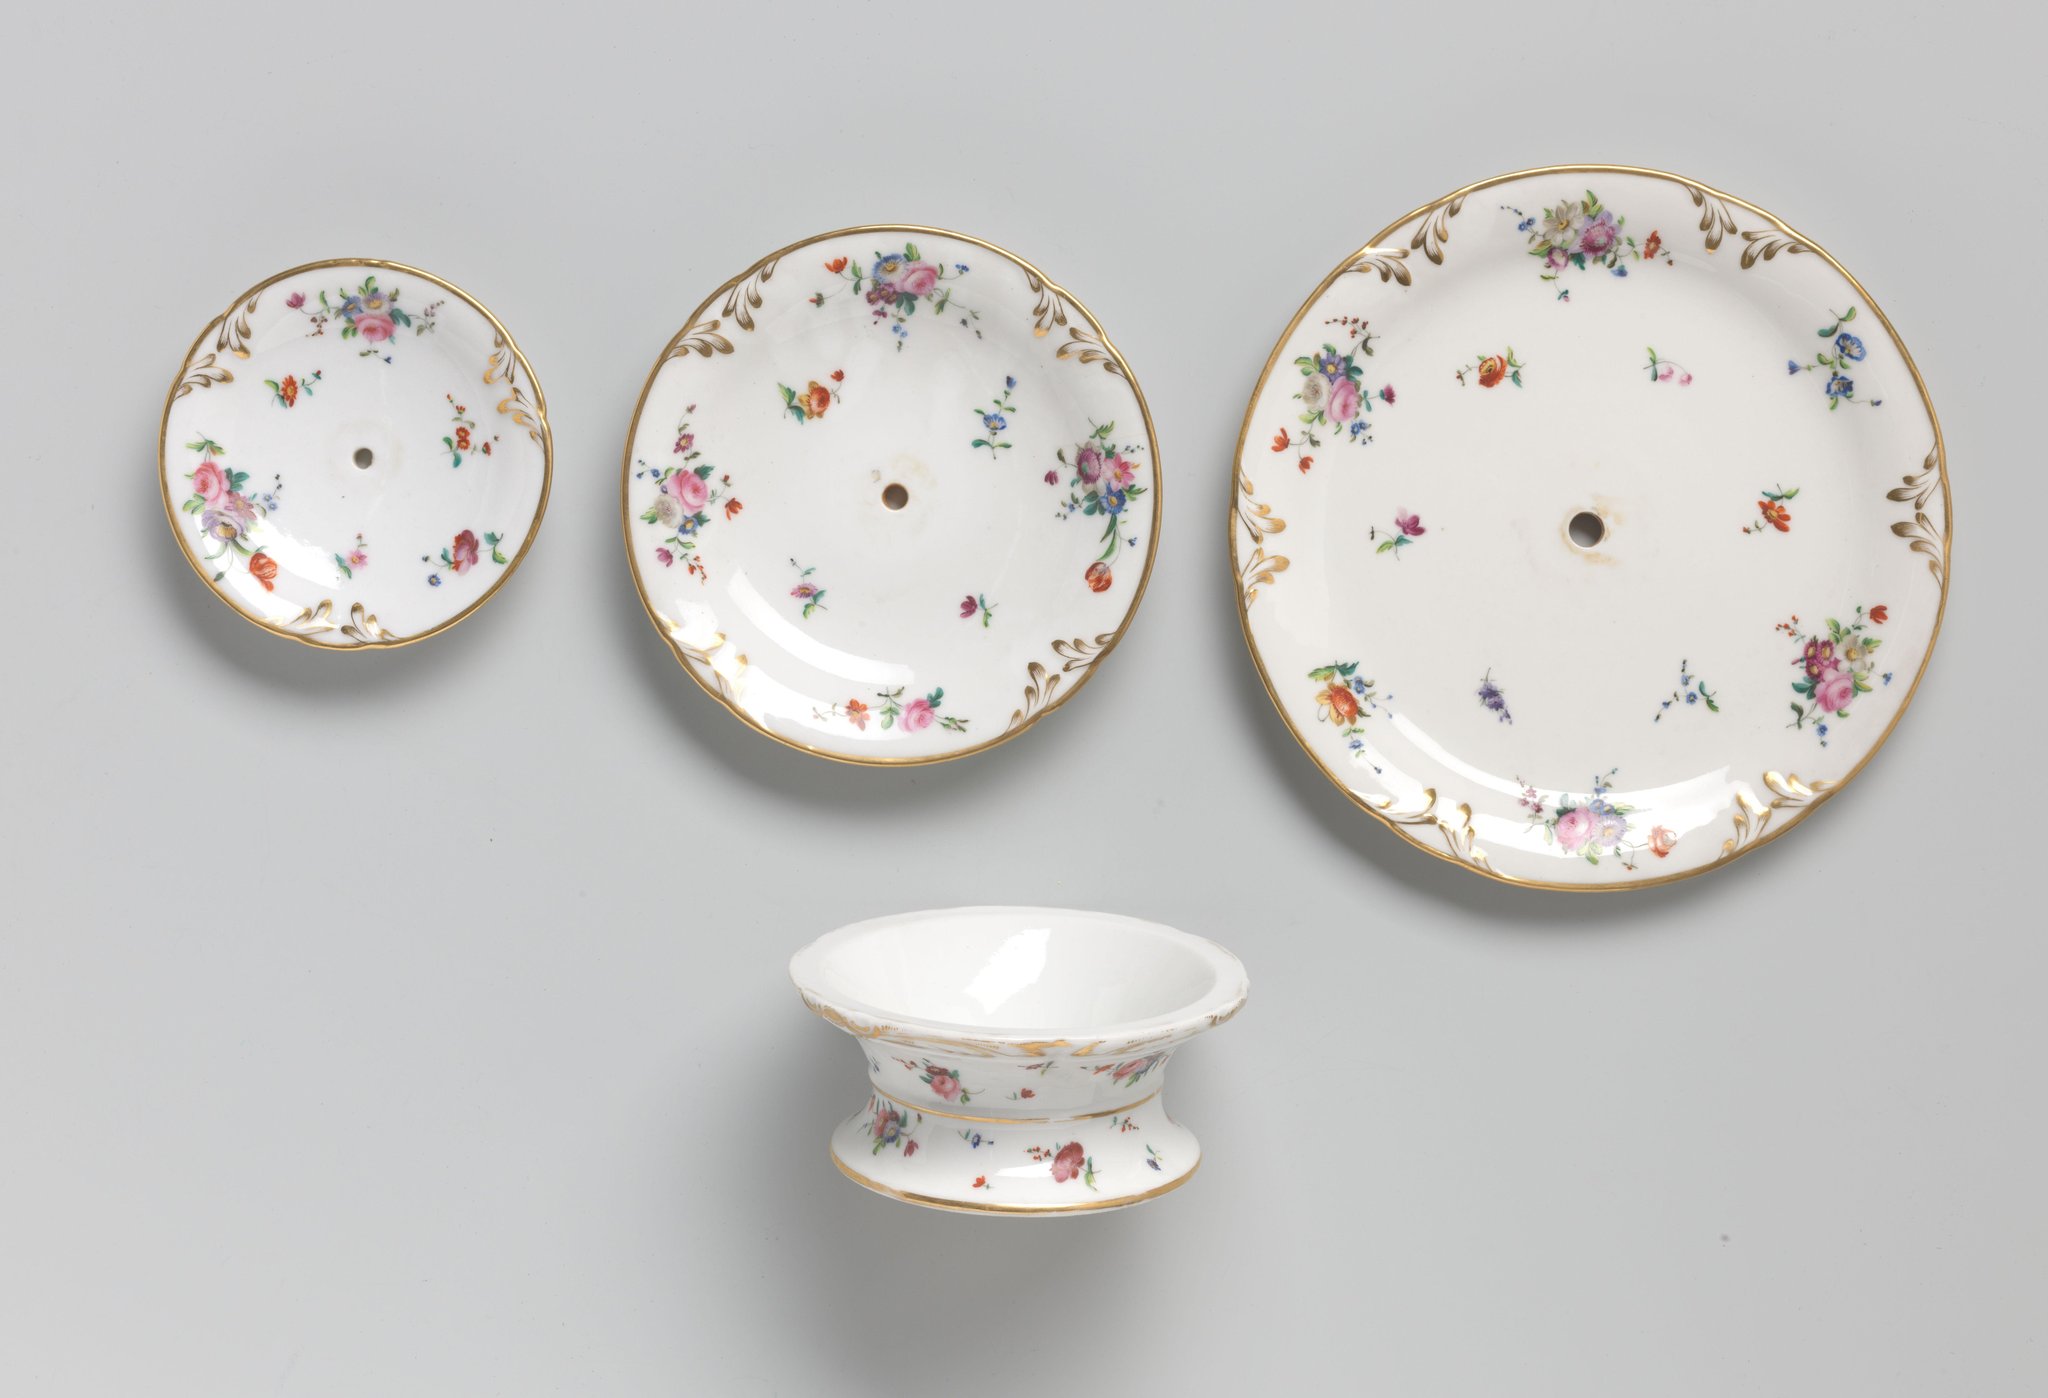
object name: étagère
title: Dish of an etagere with bouquets and flower sprays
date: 1839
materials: glaze, gold, paint, porcelain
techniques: firing, forming, gilding, turning, vitrification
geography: paris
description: De middelste schaal van een étagère van porselein, beschilderd op het glazuur in blauw, rood, roze, groen, geel, paars, zwart en goud. Versierd op de voor- en achterzijde met boeketten van verschillende bloemen en strooibloemen. Vanuit de gelobde, gouden rand, gemodelleerde bladranken, aangezet met goud.